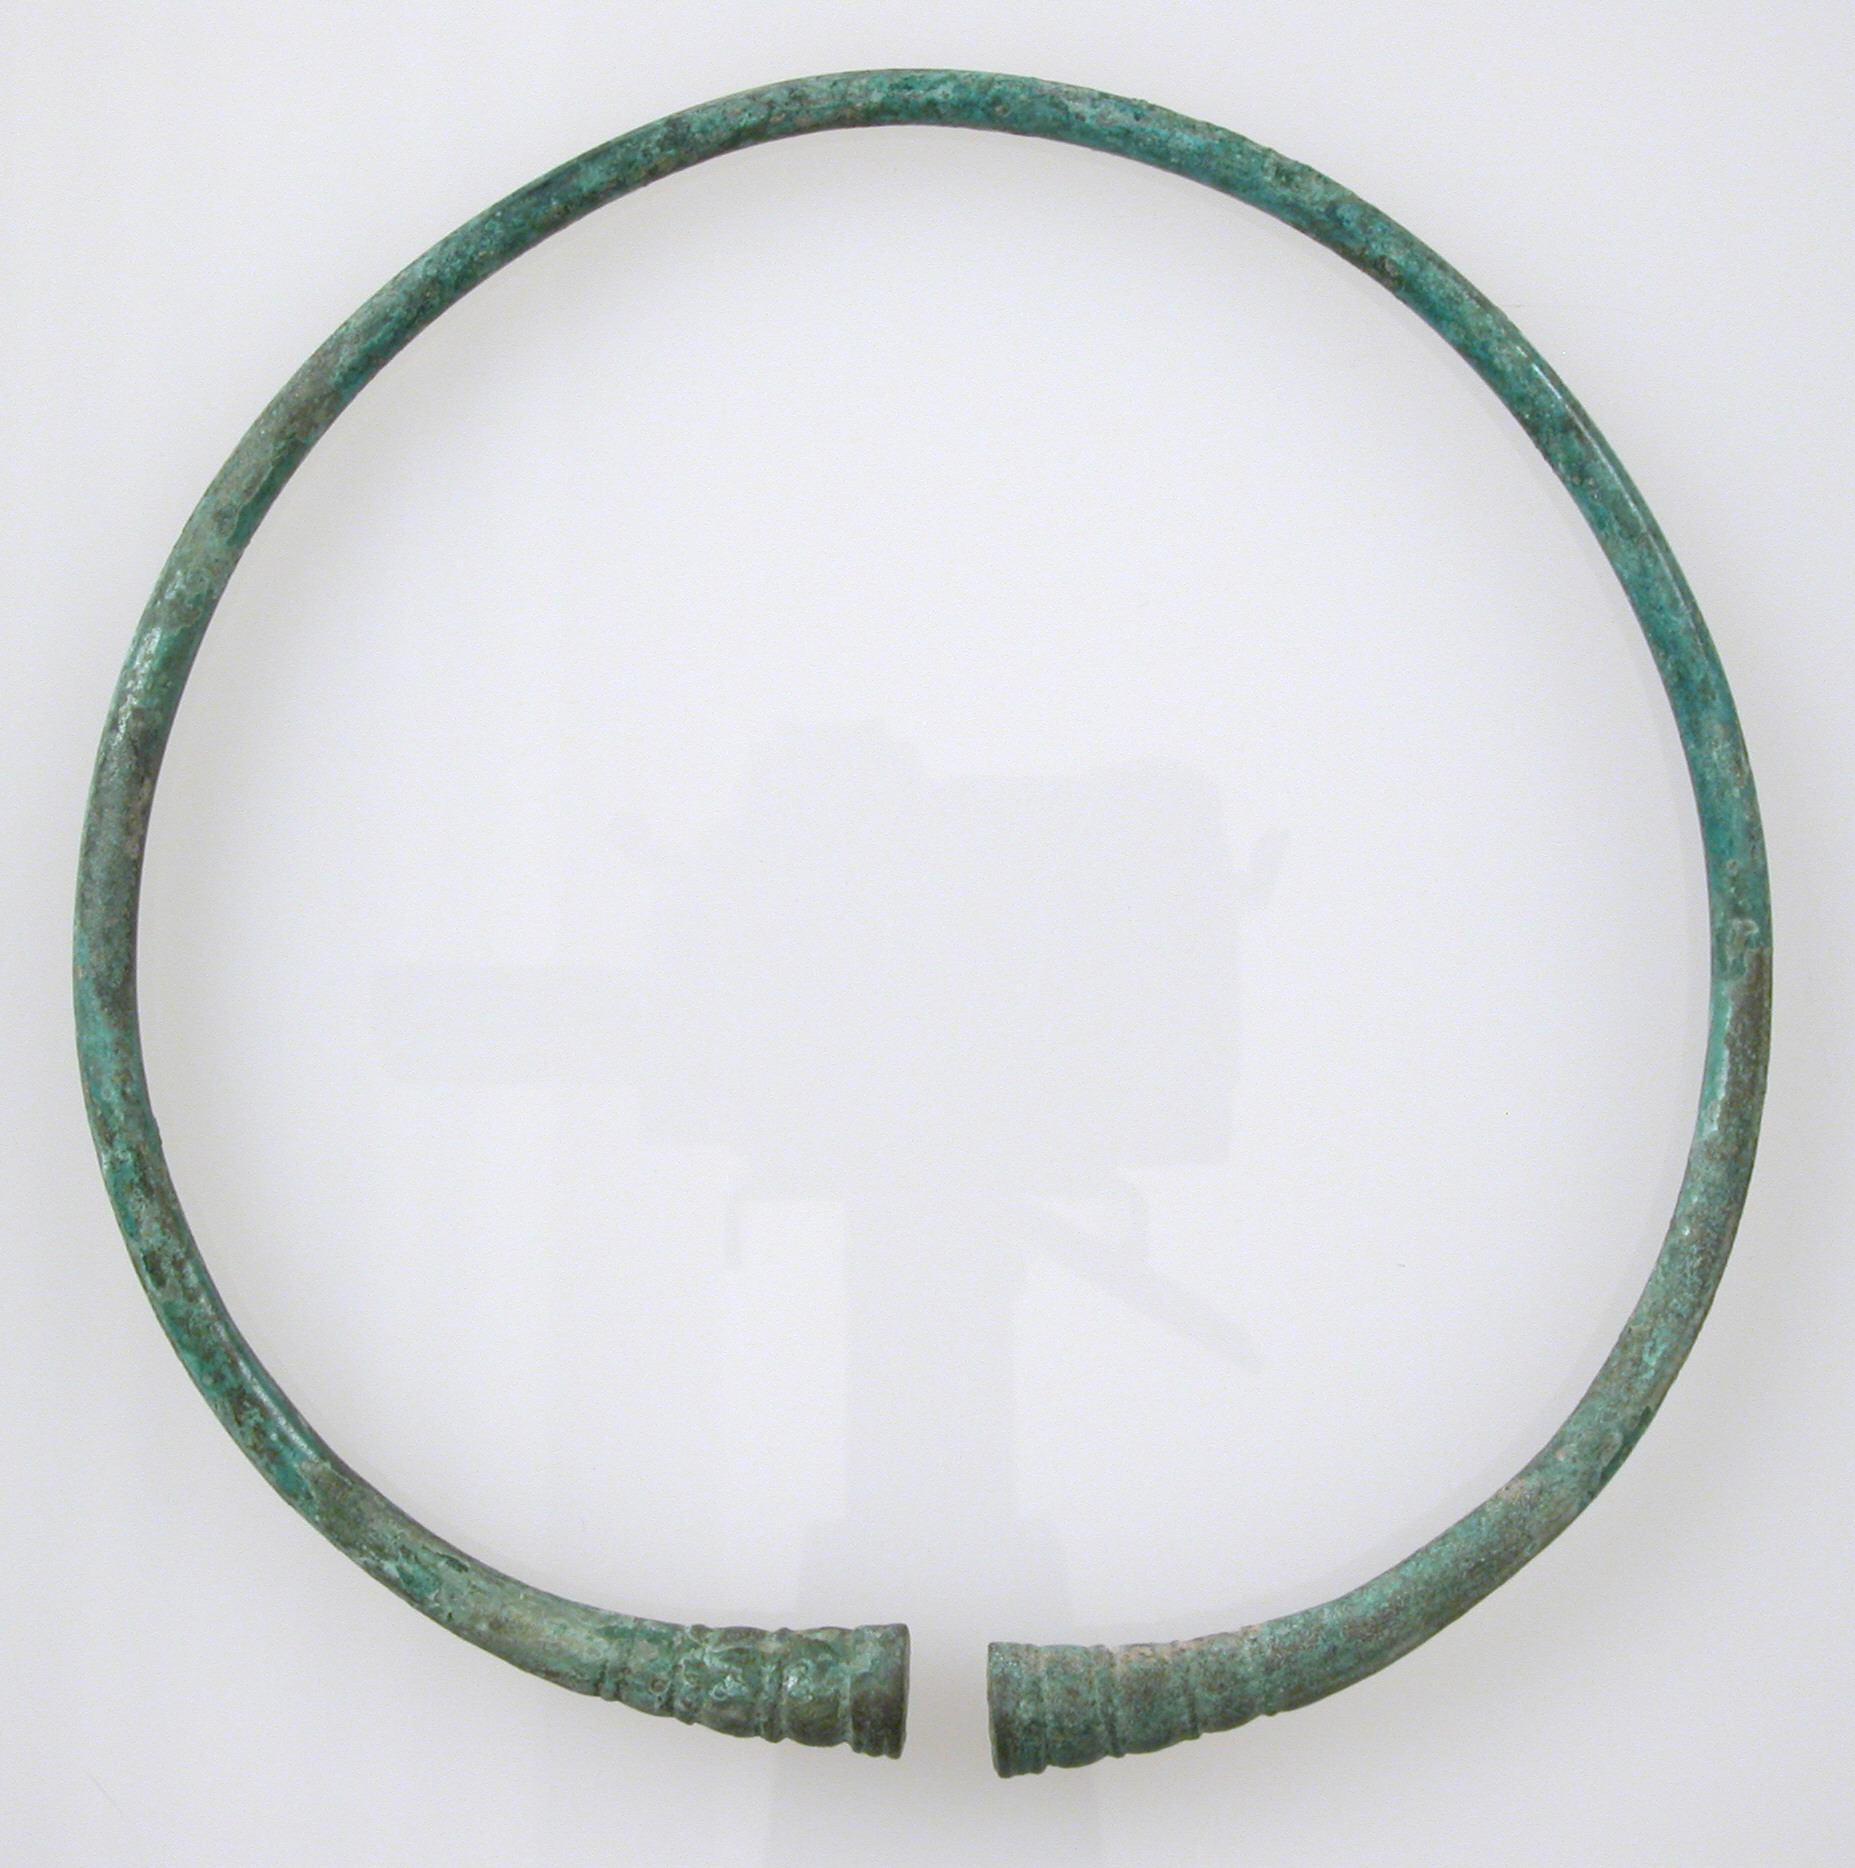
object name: torc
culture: celtic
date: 400-201 BCE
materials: copper alloy